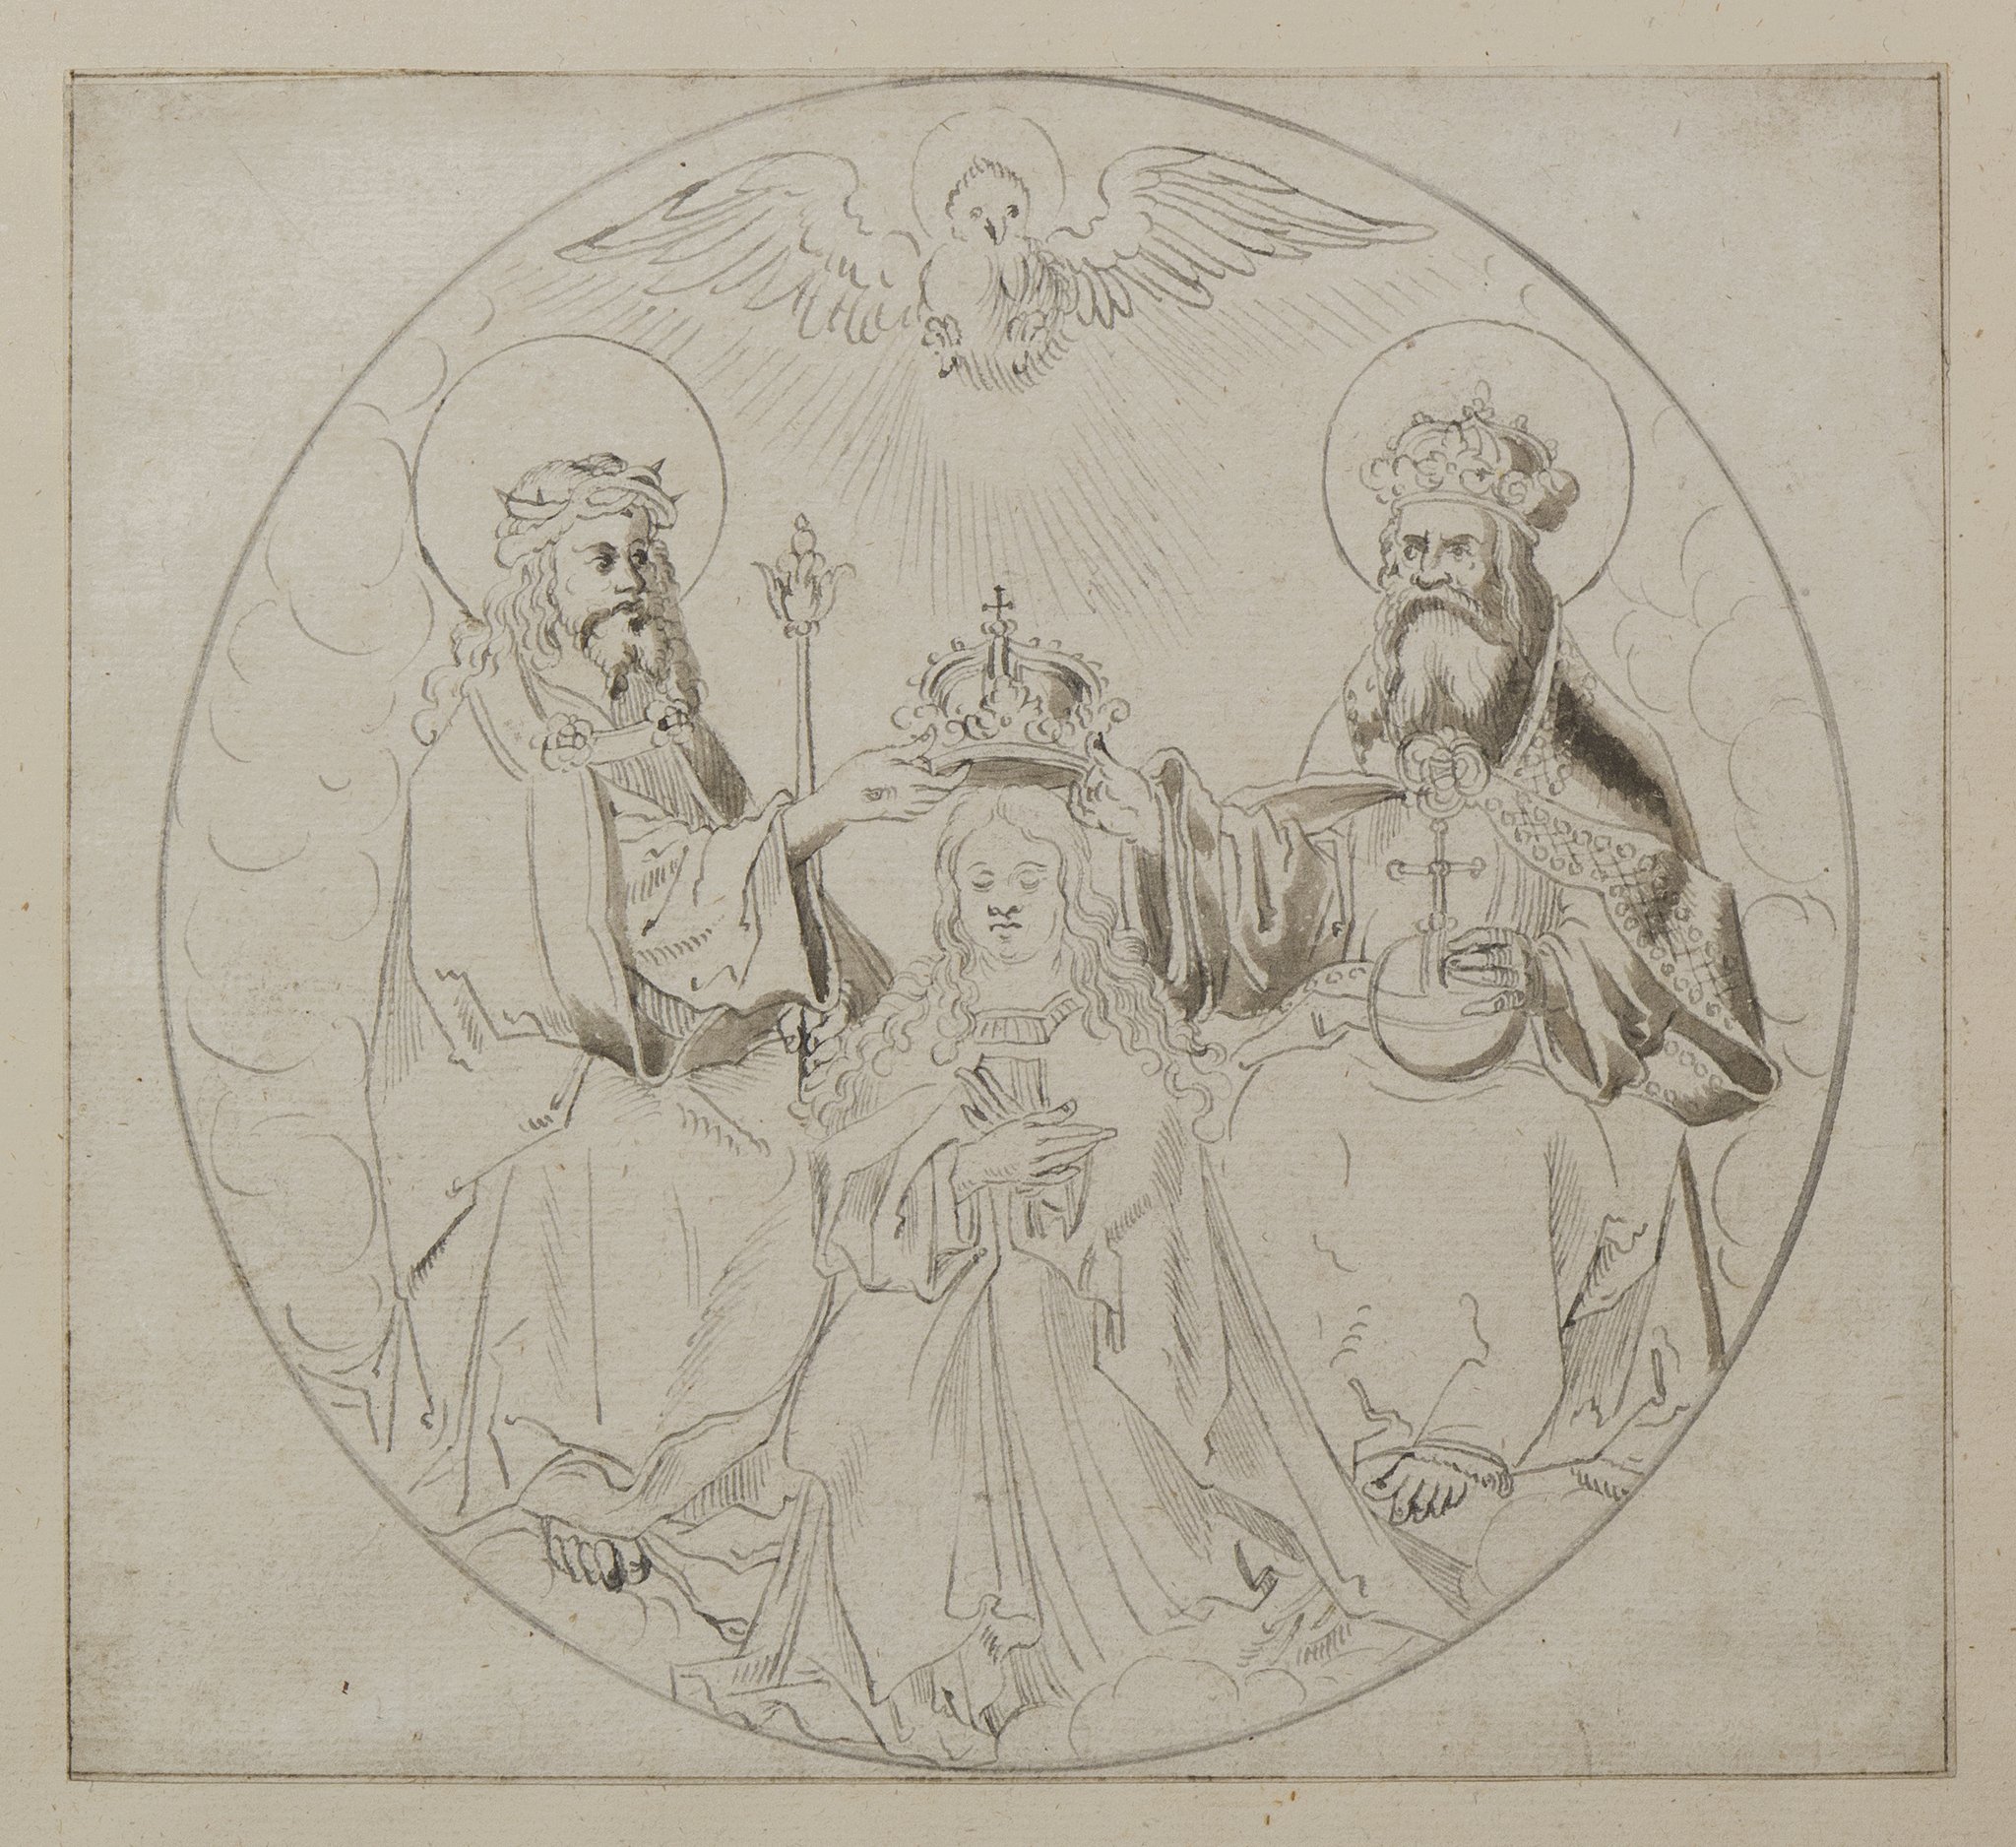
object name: drawing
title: Coronation of the Virgin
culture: south netherlandish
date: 1500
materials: ink, paper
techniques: pen, wash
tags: doves,virgin mary,god the father